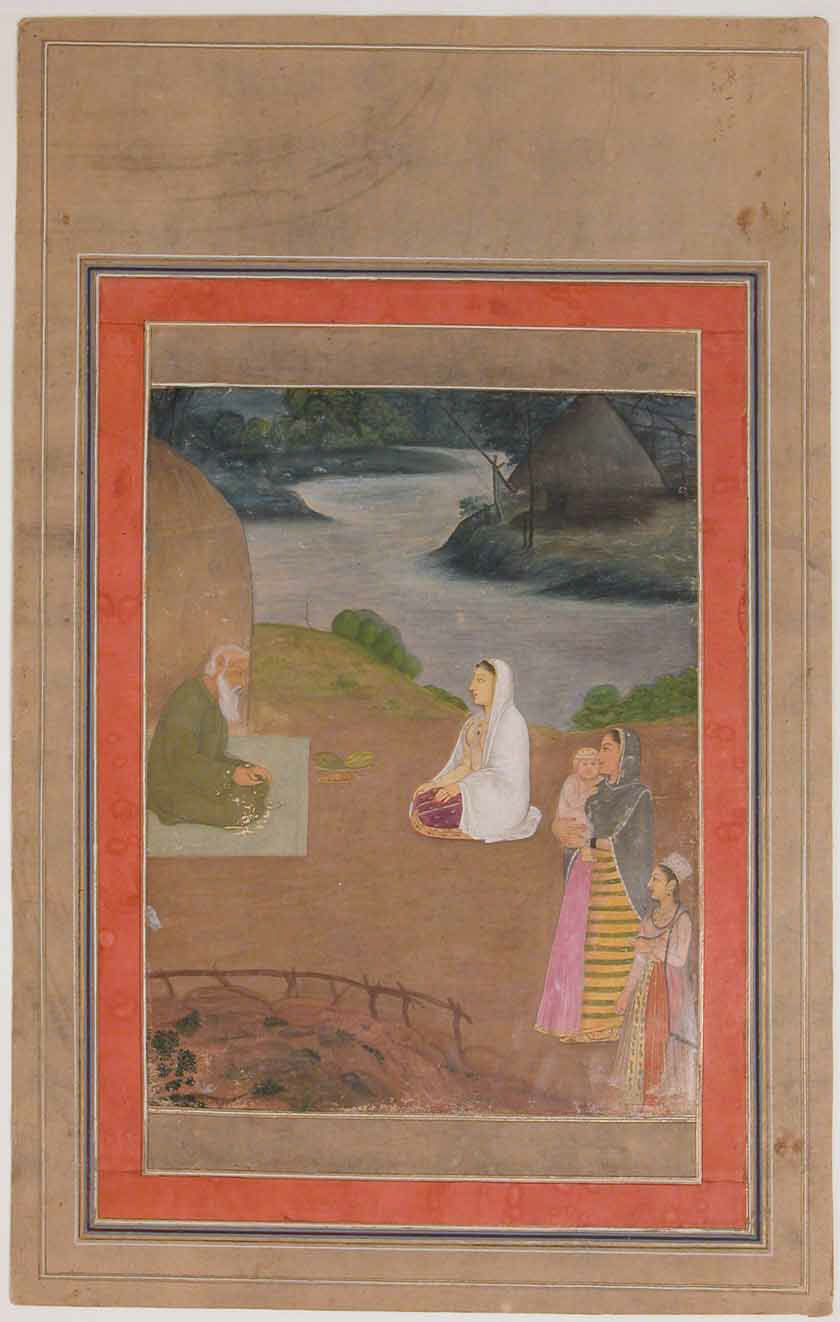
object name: illustrated album leaf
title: "Women Visiting a Hermit", Folio from the Davis Album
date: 1701-1800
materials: gold, ink, paper, watercolor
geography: india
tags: infants,men,women